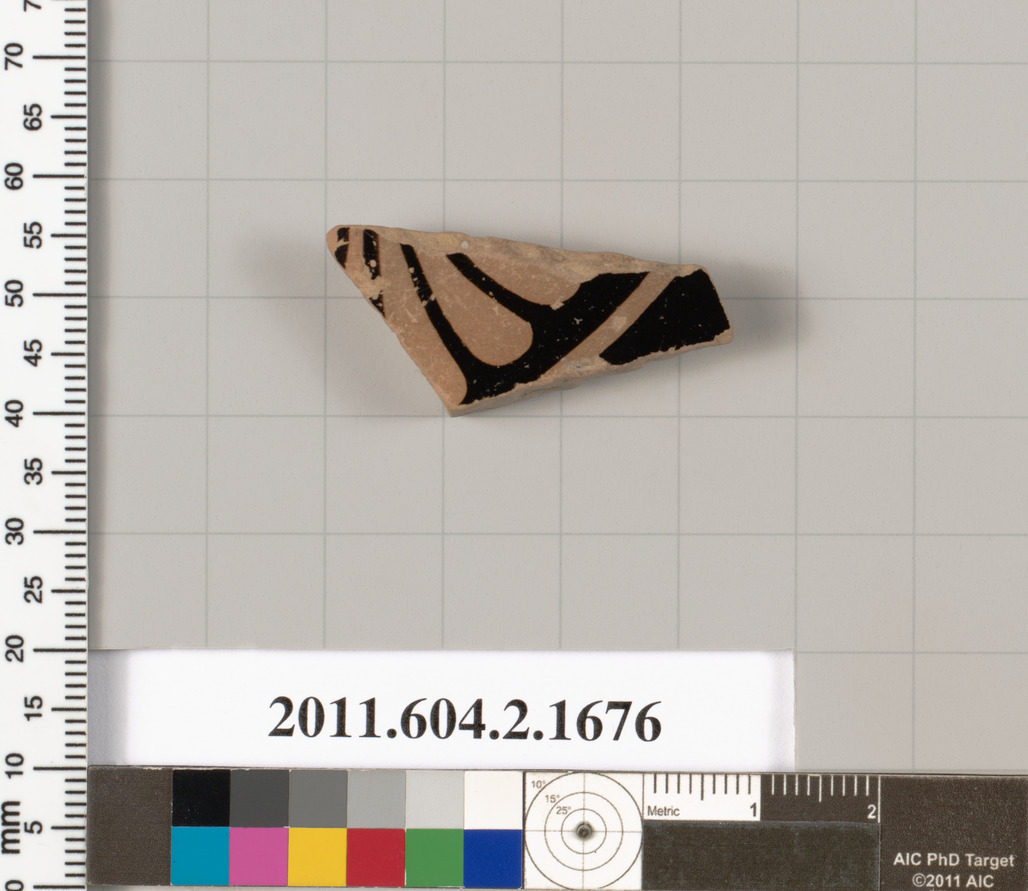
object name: skyphos fragment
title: Terracotta fragment of a skyphos (deep drinking cup)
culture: greek, attic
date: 460-440 BCE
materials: terracotta